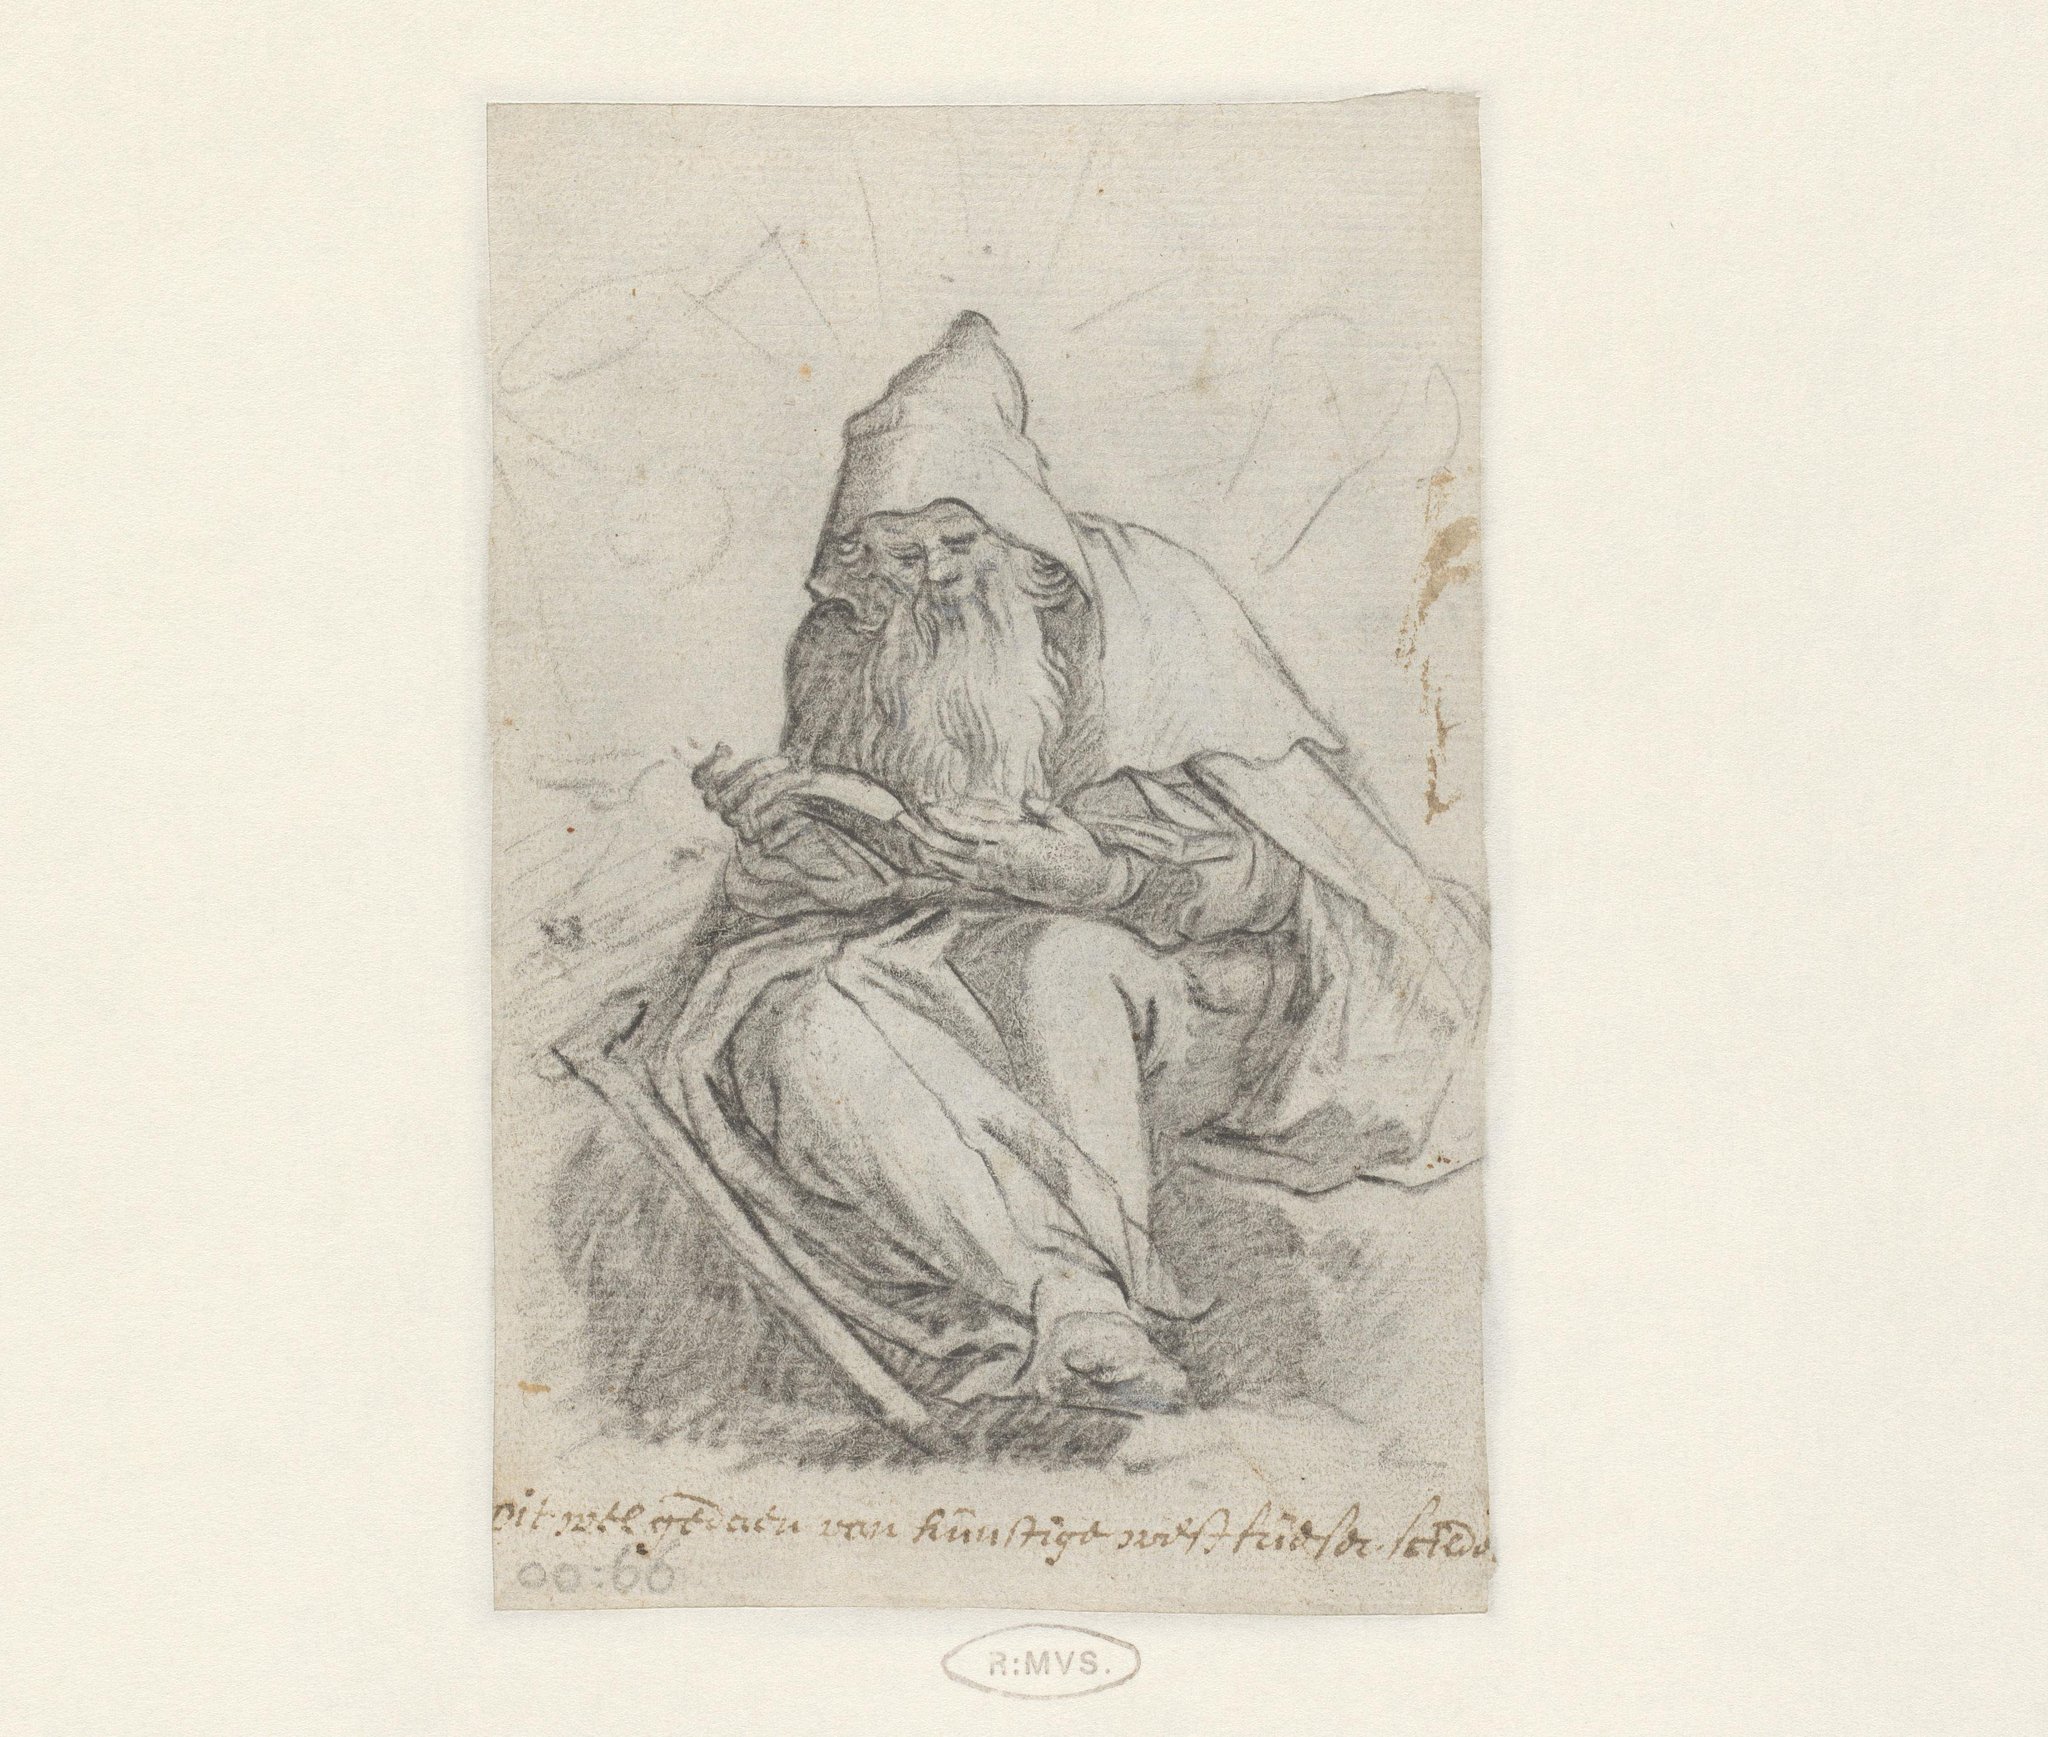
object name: drawing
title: H. Antonius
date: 1612-1700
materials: chalk, paper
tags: the hermit antony abbot (antonius abbas) of egypt, also called the great; possible attributes: bell, book, t-shaped staff, flames, pig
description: Kopie naar prent van Boëtius Adamsz. Bolswert.